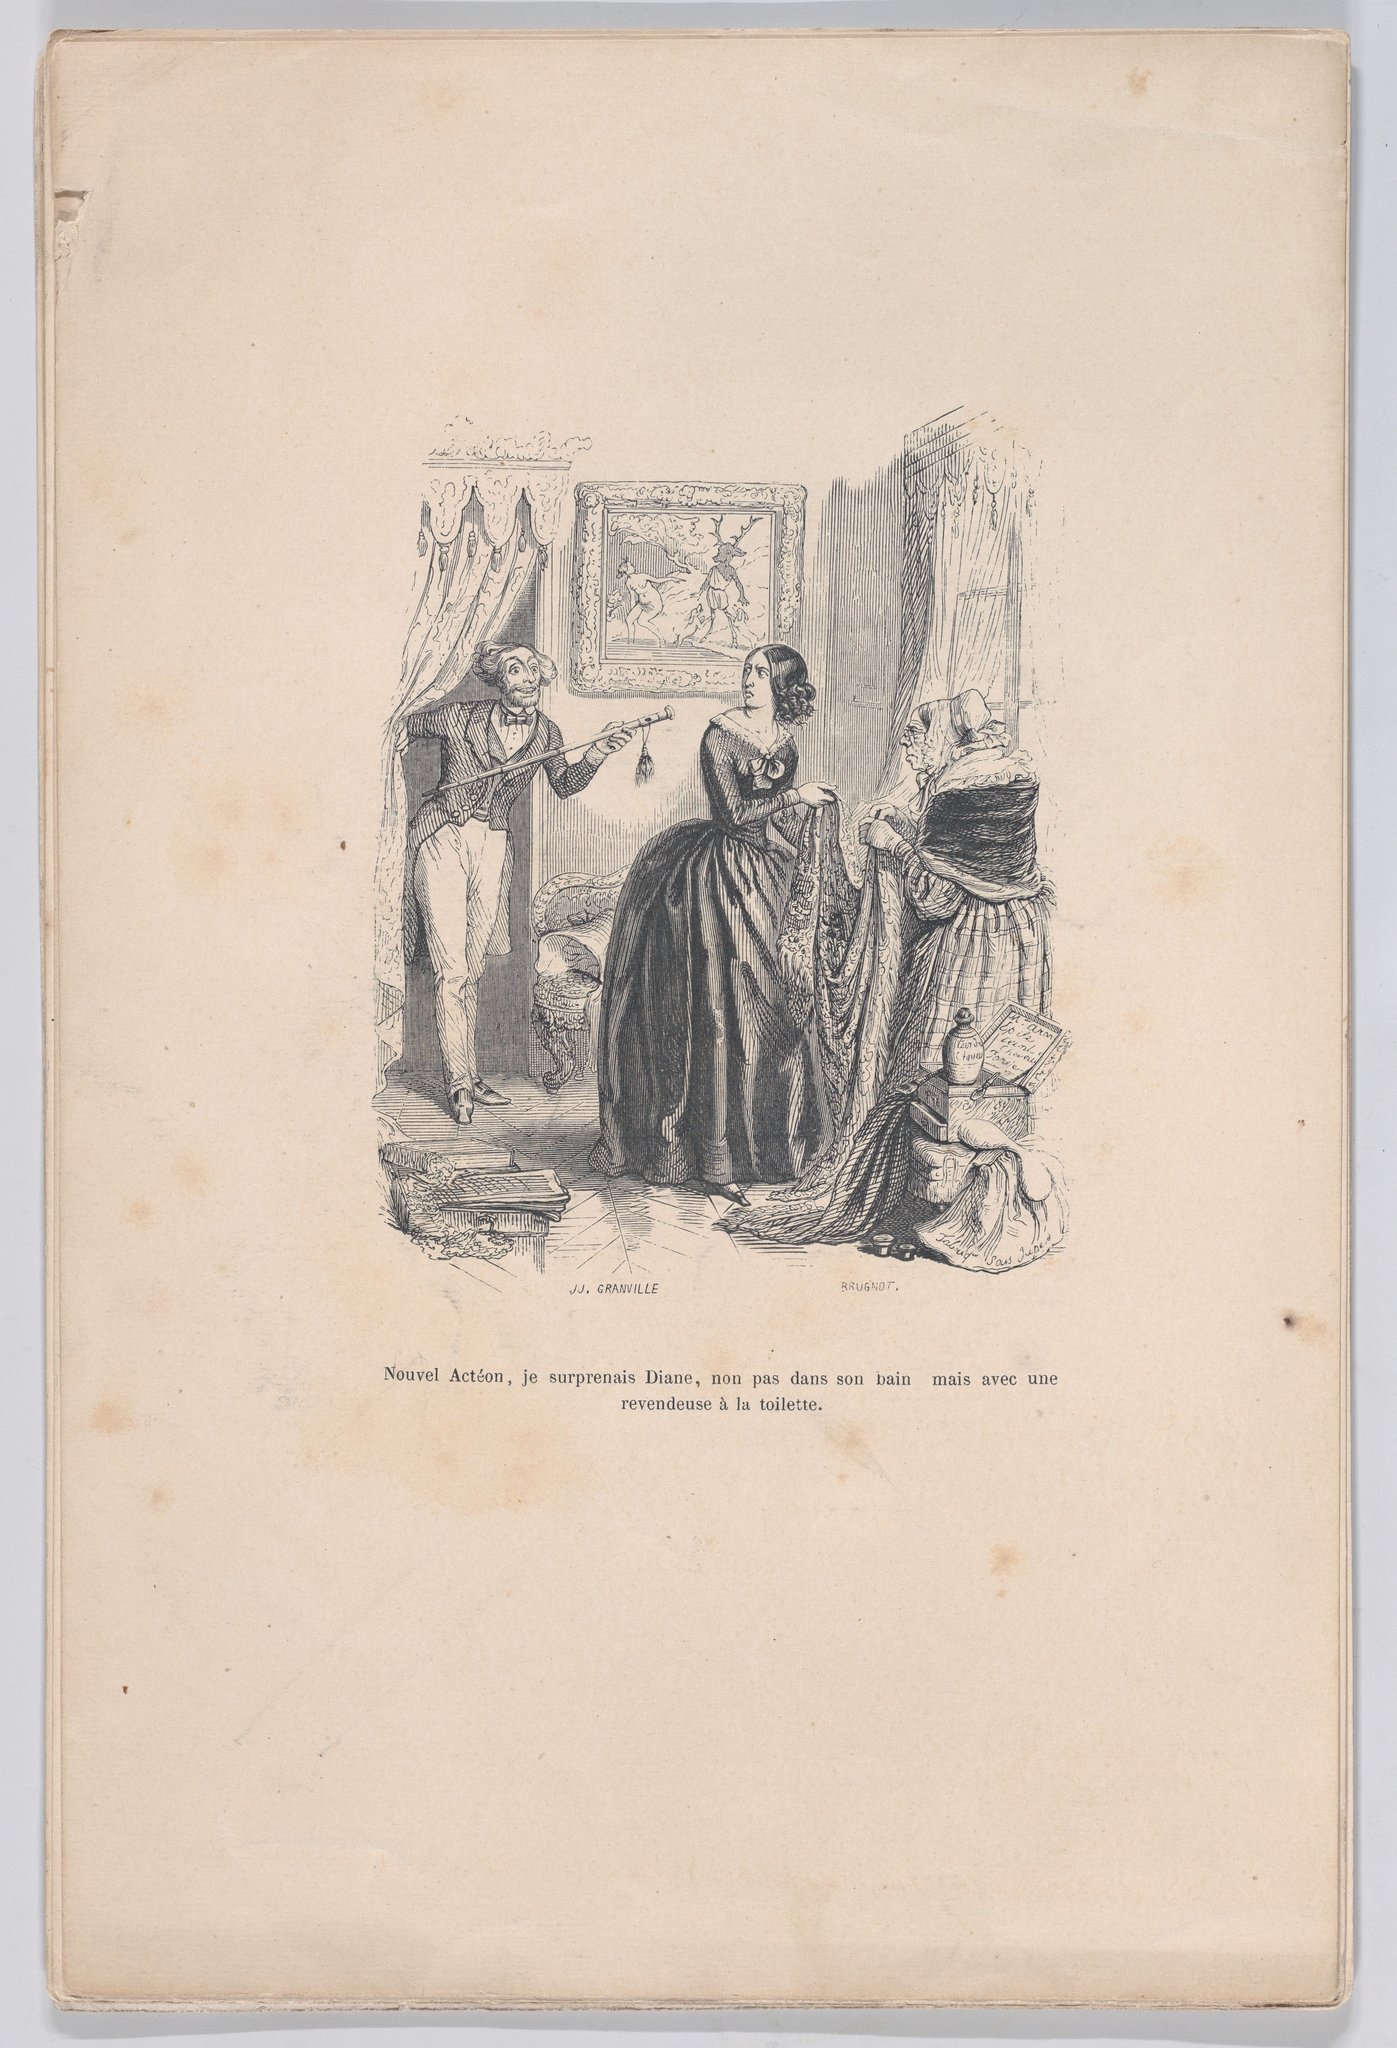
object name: print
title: As the new Actaeon, I surprised Diana, not in her bath but with a dealer in the bathroom, from "Little Miseries of Human Life"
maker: j. j. grandville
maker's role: illustrator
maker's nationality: french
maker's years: 1803-1847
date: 1843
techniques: engraving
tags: men,women